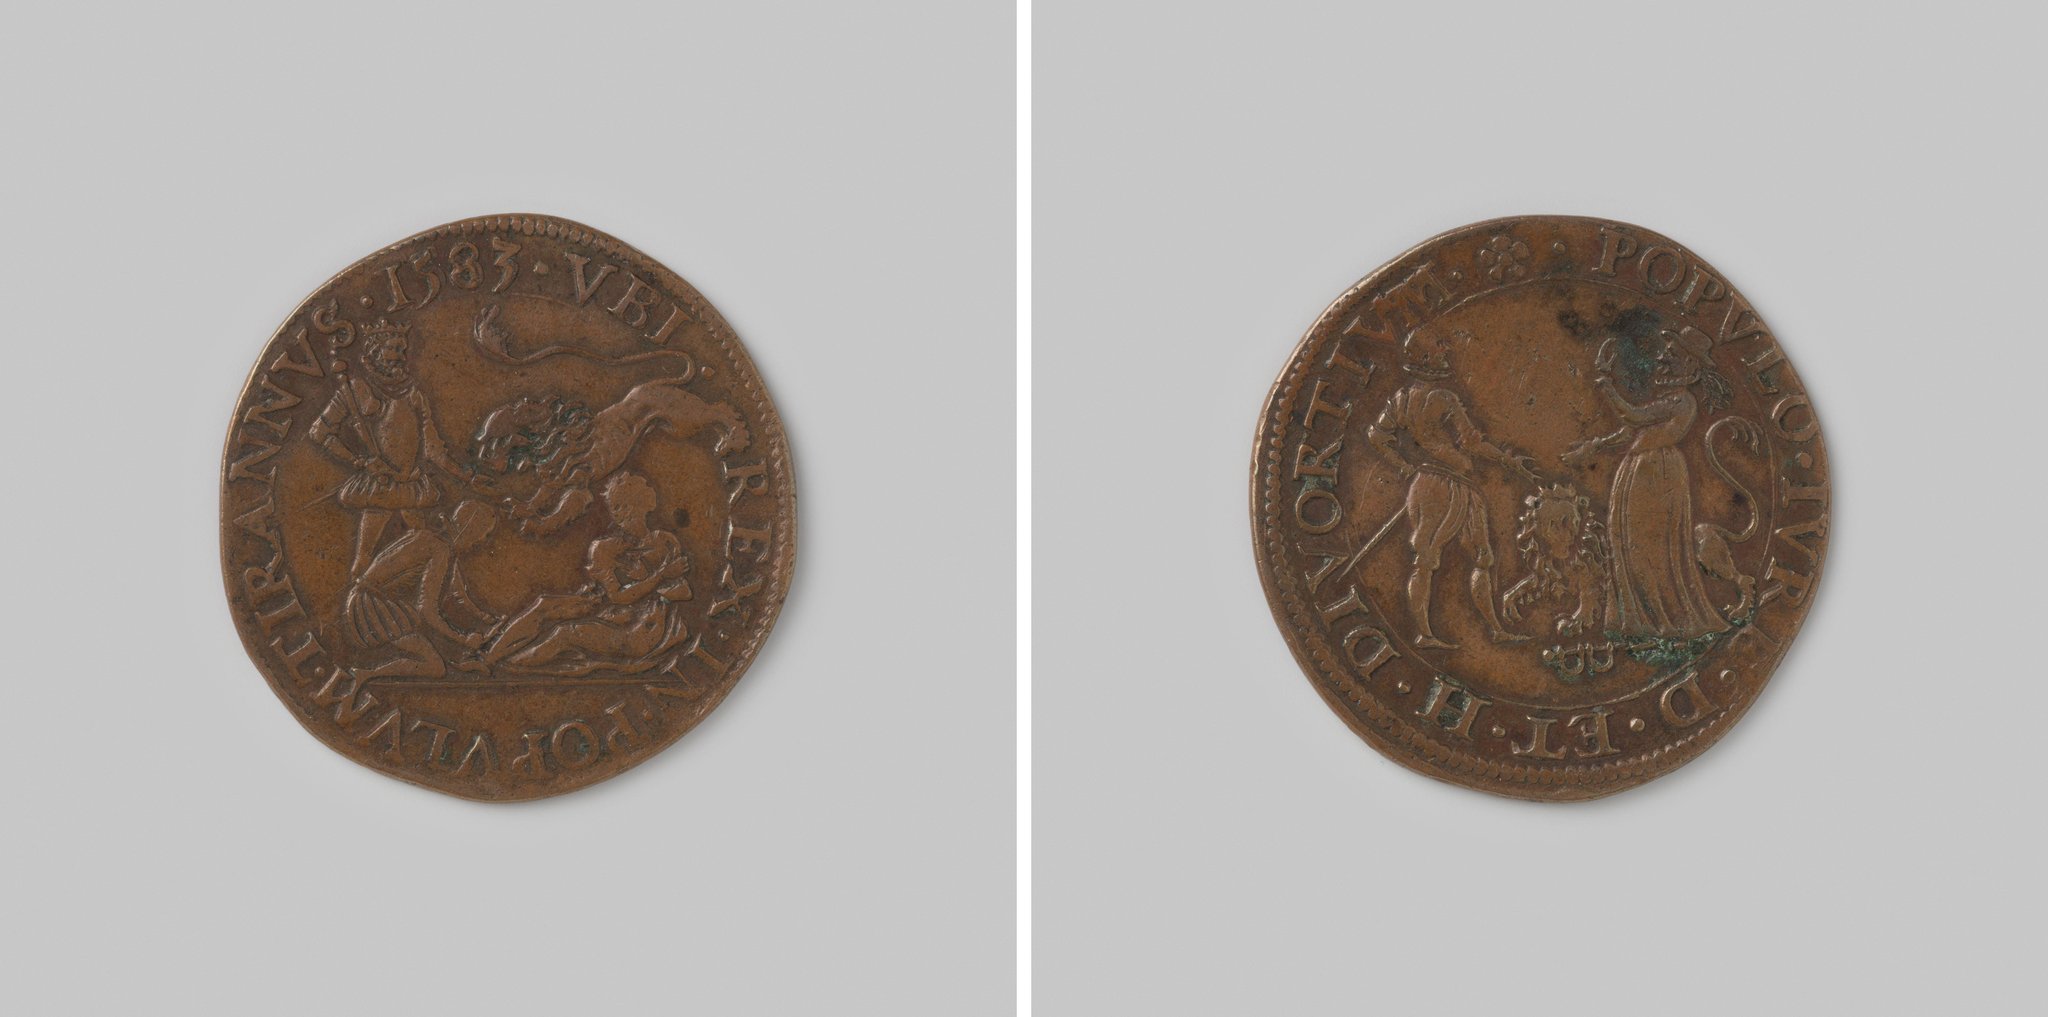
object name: history medal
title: Rekenpenning uit Dordrecht op de afkeer van de Nederlanders tegen de Hertog van Anjou 1583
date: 1583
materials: copper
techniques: striking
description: Koperen penning, op de voorzijde een leeuw die de Hertog van Anjou bespringt die de Nederlanden, als liggende vrouw, de voeten kluistert, waarbij de Spaanse koning toekijkt, met omschrift, op de keerzijde de Nederlanden, als vrouw met hoed met een leeuw aan haar zijde, die Anjou afwijst, met omschrift.